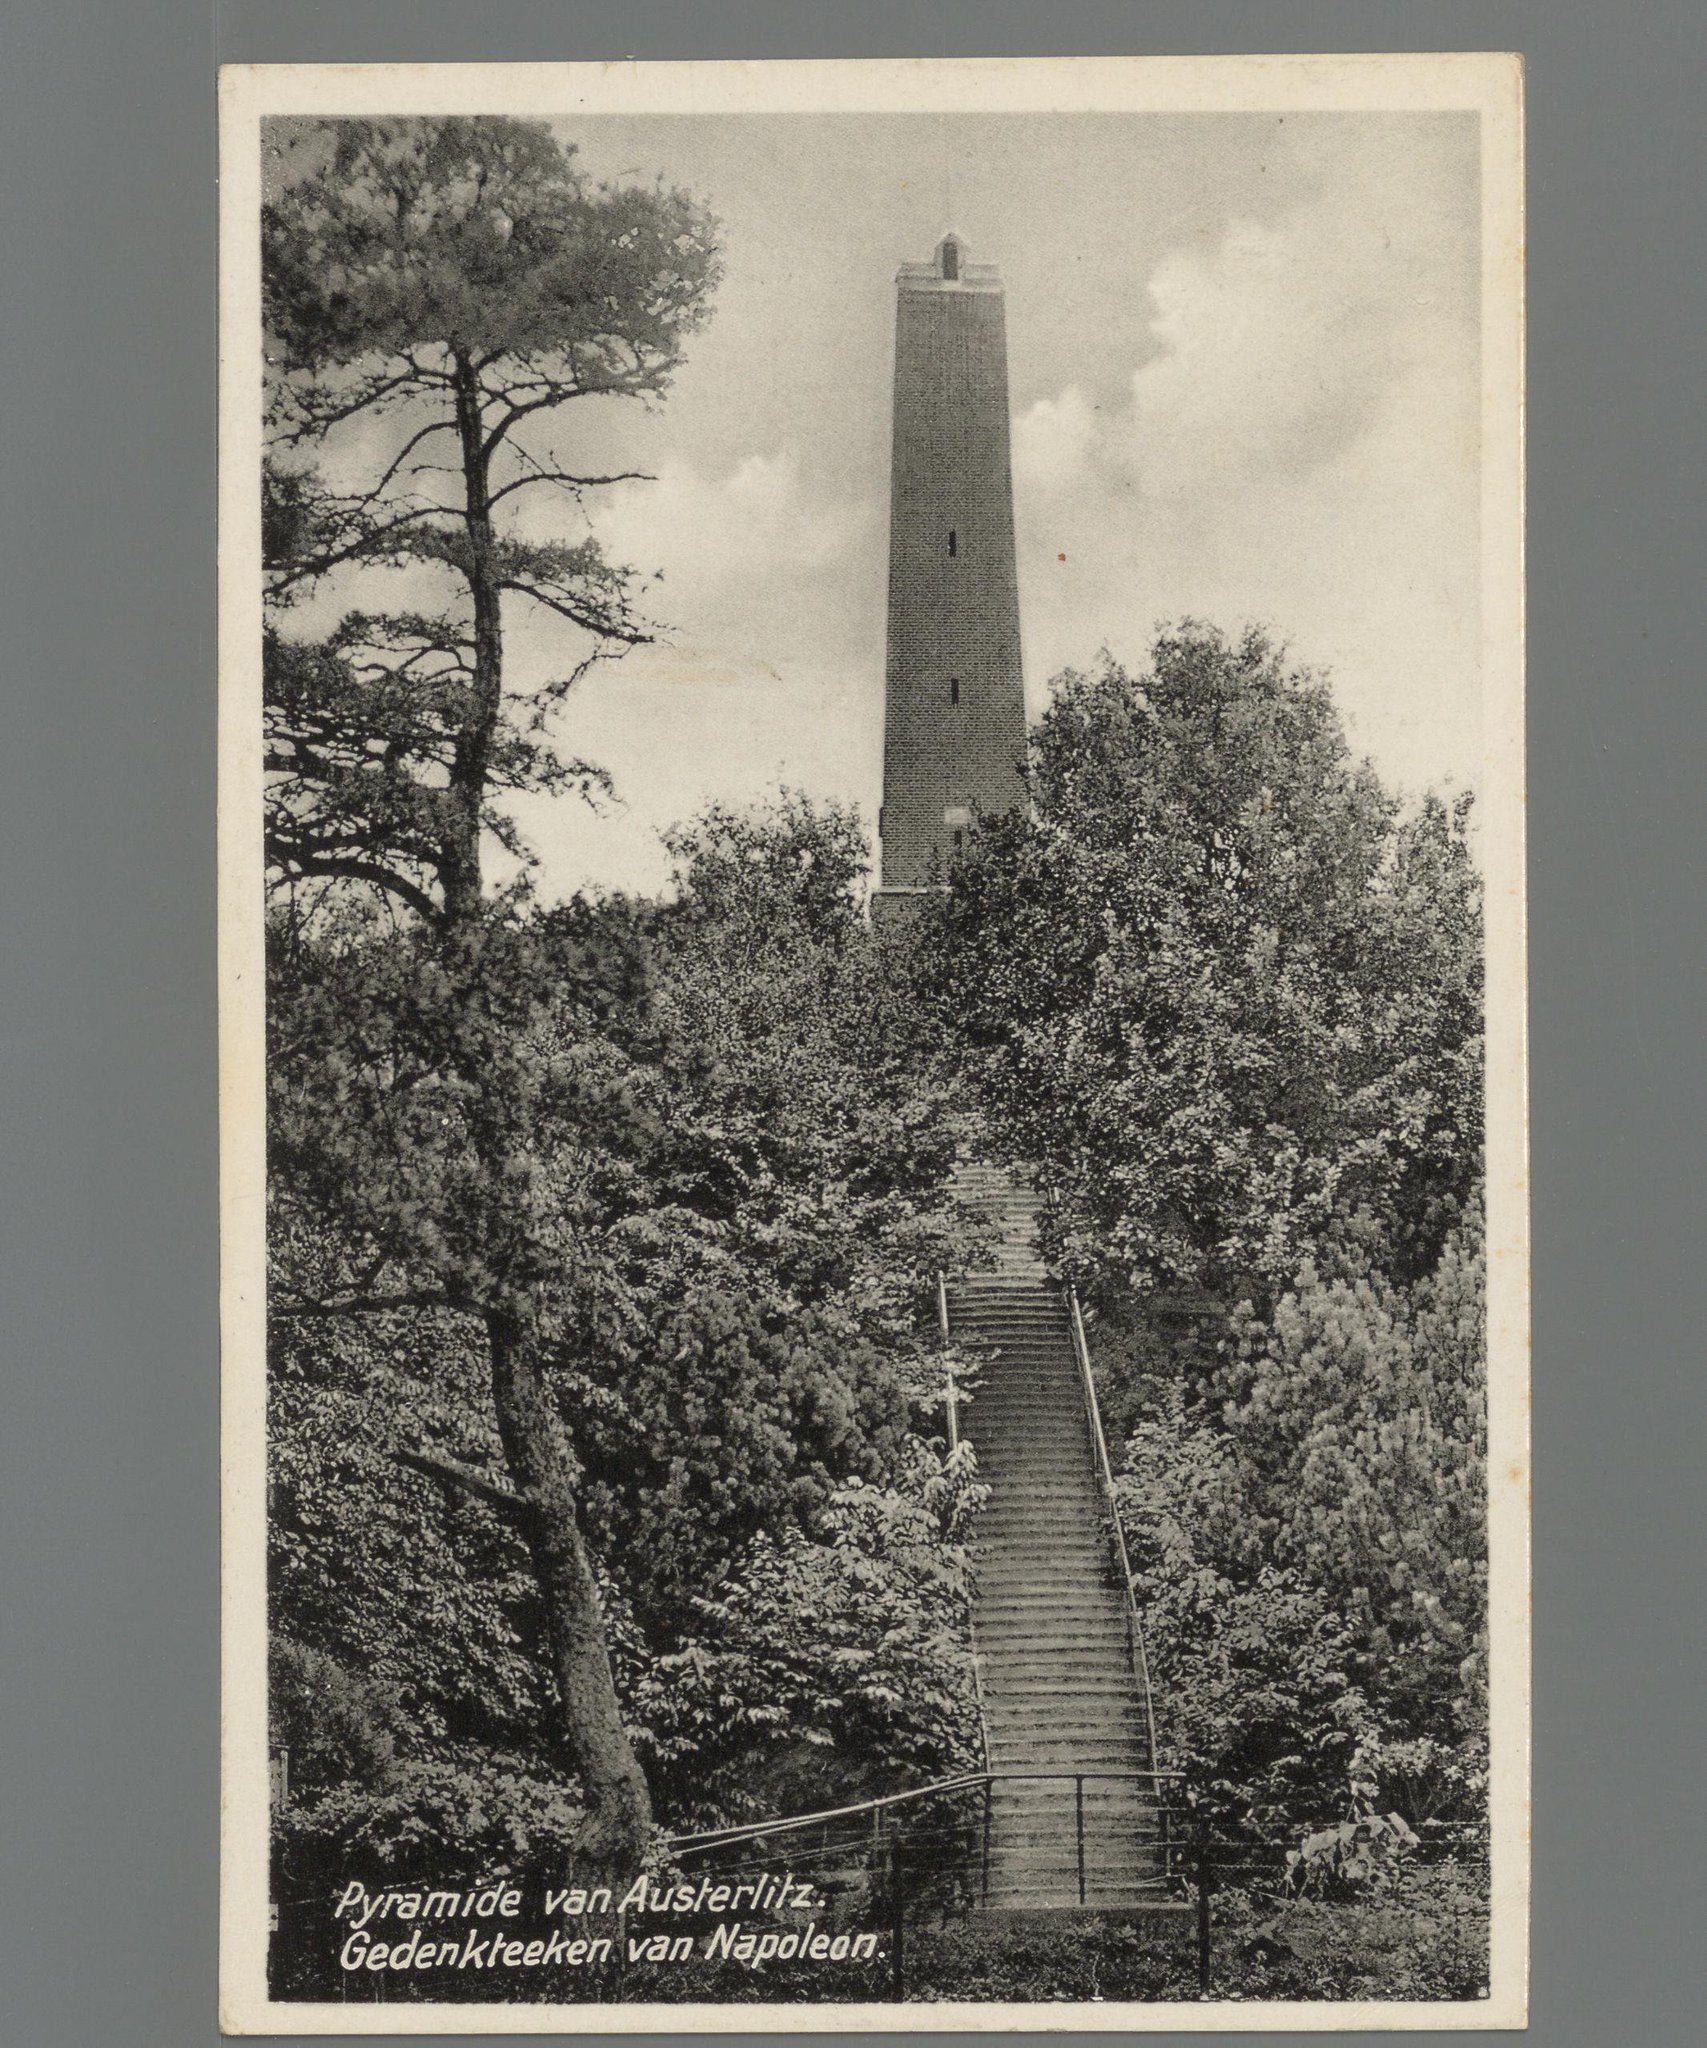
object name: photomechanical print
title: Pyramide van Austerlitz. Gedenkteeken van Napoleon.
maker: Anonymous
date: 1929-1939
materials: cardboard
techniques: photograph, writing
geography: maarn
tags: other memorial structures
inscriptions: postage stamp, copyright notice: ‘Copyright-Coerdes-Baarn.’